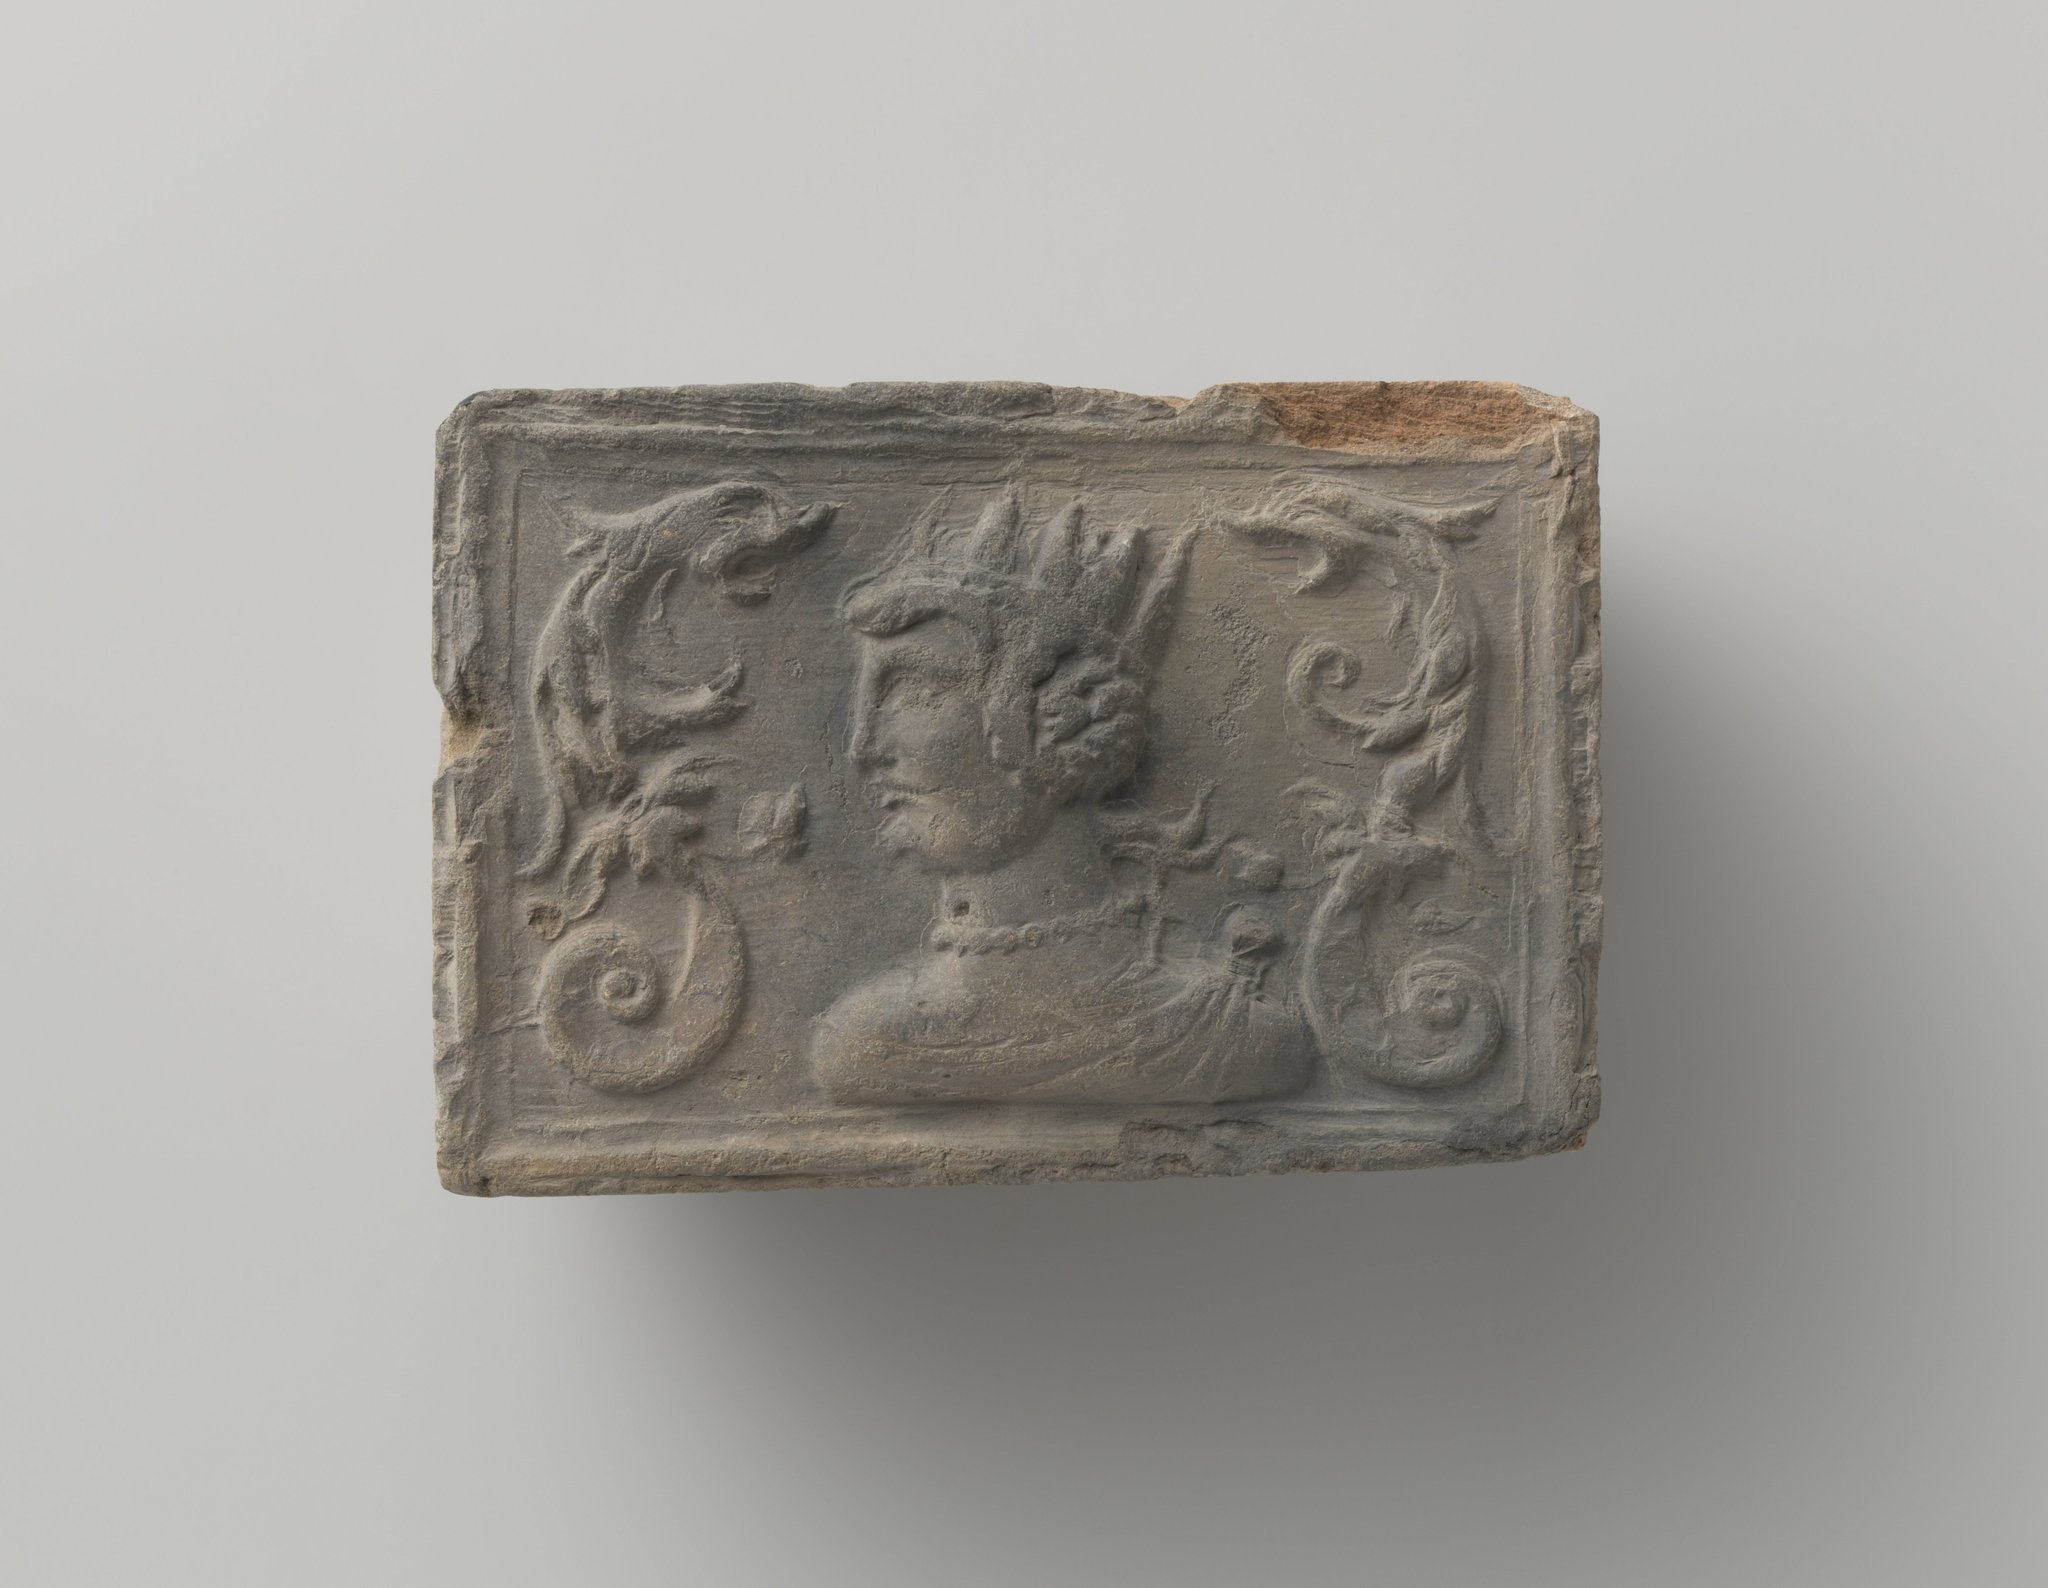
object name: hearthstone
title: Haardsteen met in het midden een gekroond vrouwenhoofd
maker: Anonymous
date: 1500-1600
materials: earthenware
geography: southern netherlands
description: Haardsteen met in het midden een gekroond vrouwenhoofd, in vrij hoog reliëf profiel. Rechts en links twee chimères.